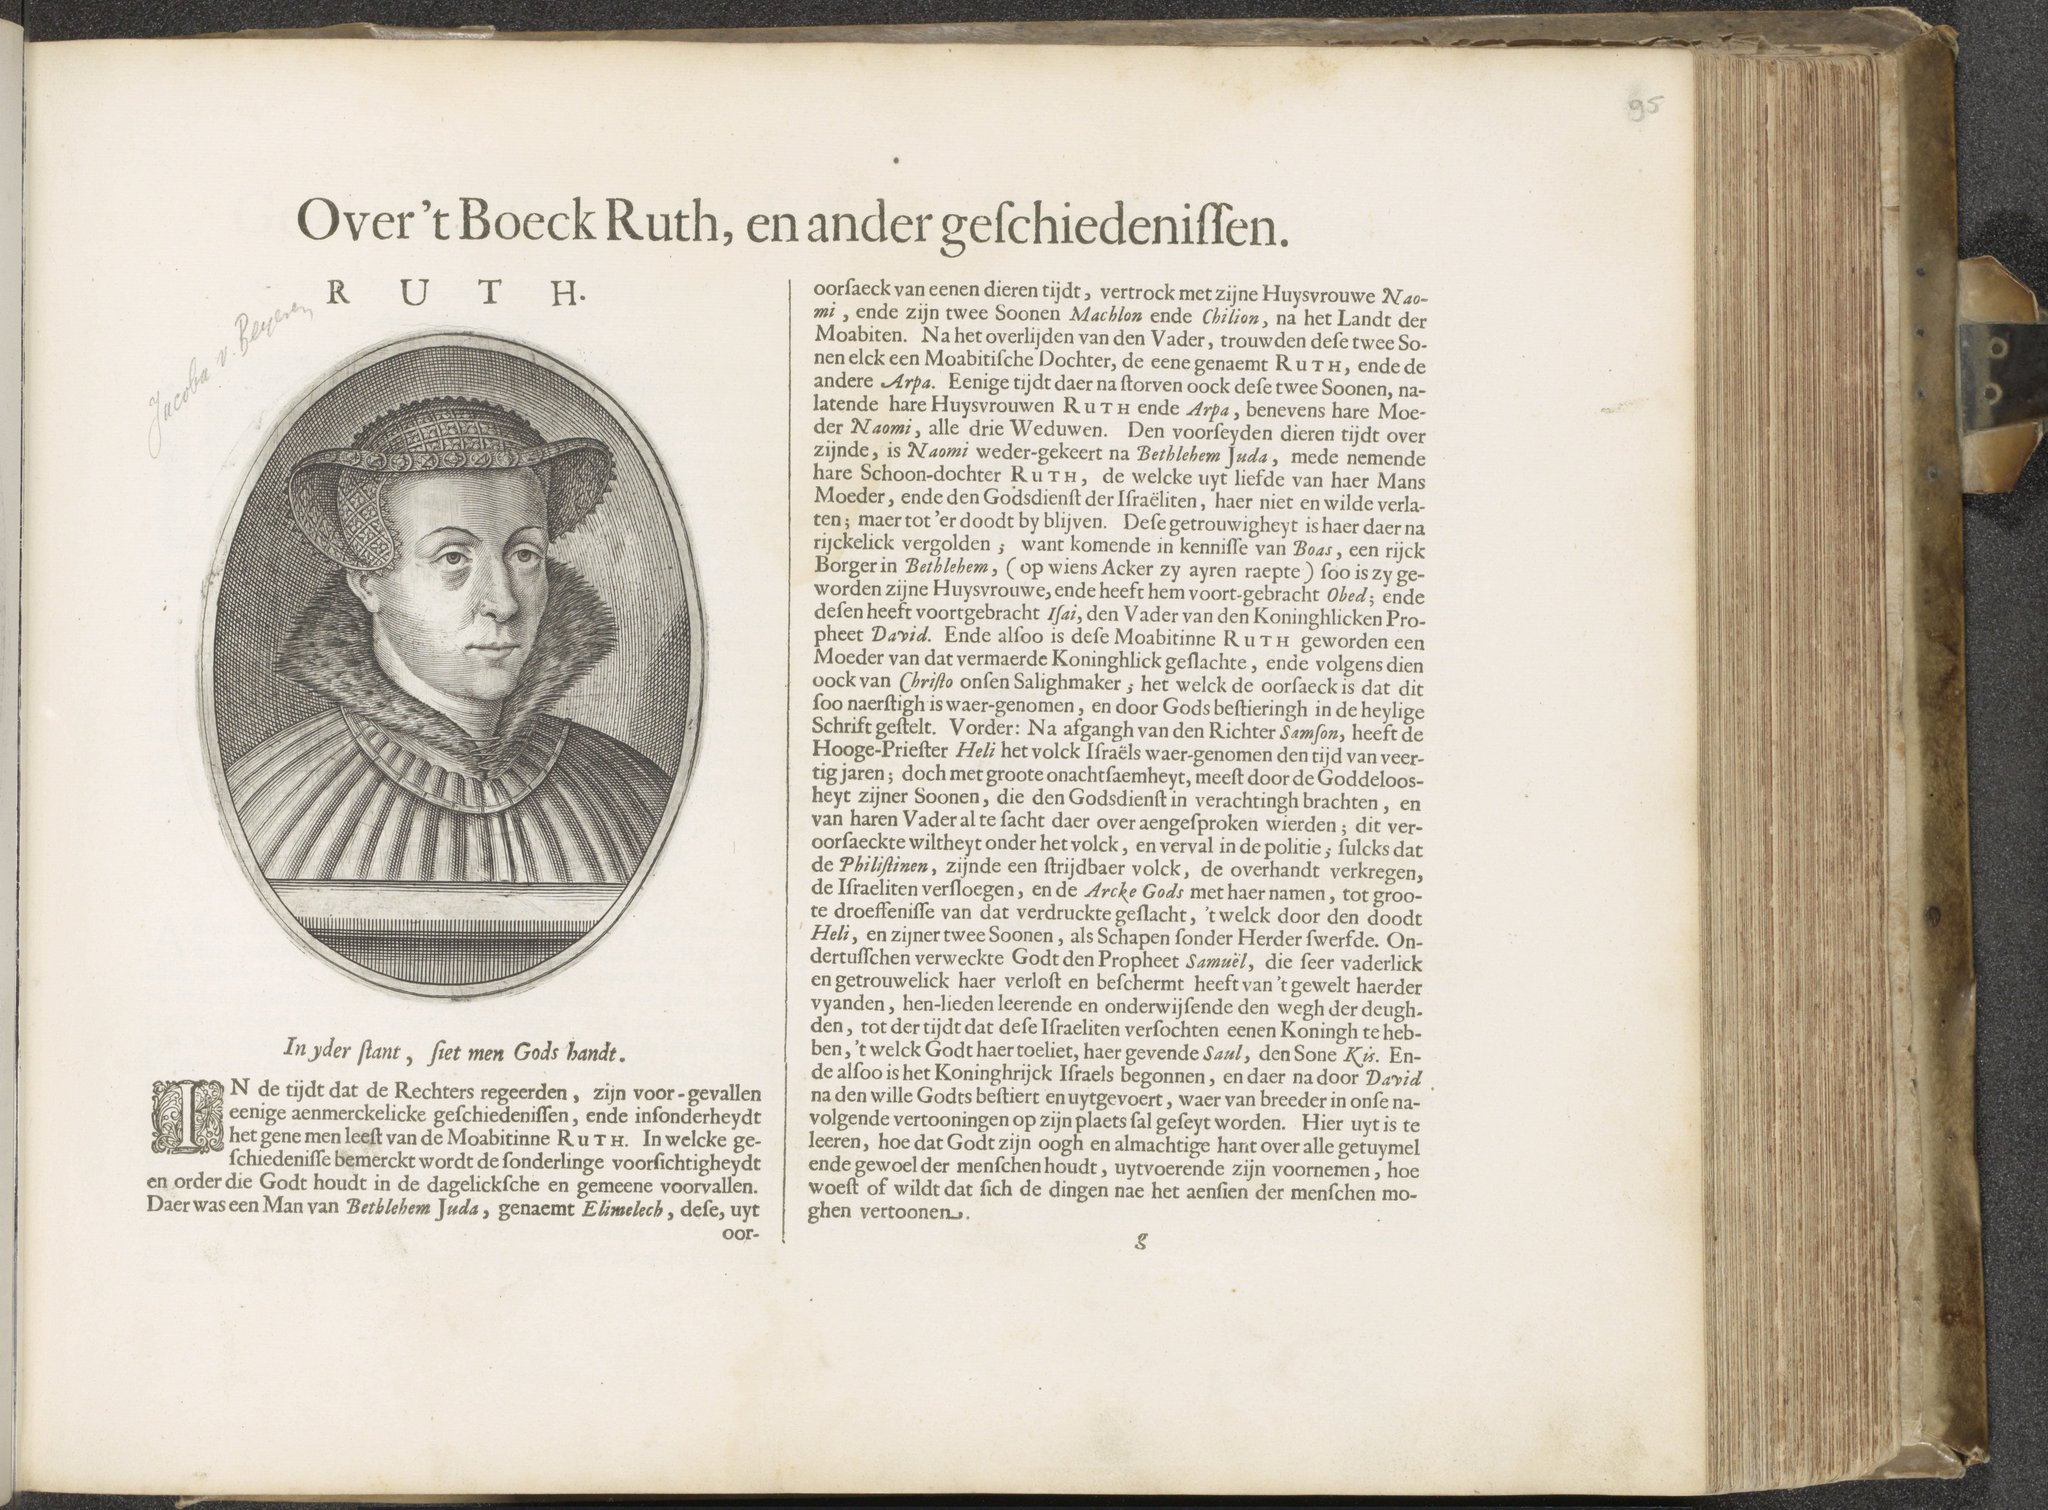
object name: text sheet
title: Portret van de Moabitische Ruth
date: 1610-1625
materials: paper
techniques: engraving, letterpress printing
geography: amsterdam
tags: jacoba of bavaria (countess of hainaut)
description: Portret van Jacoba van Beieren, in dit album gebruikt als afbeelding van de Moabitische Ruth. De begeleidende tekst begint met een kleine gedecoreerde initiaal I. Het blad maakt deel uit van een album.